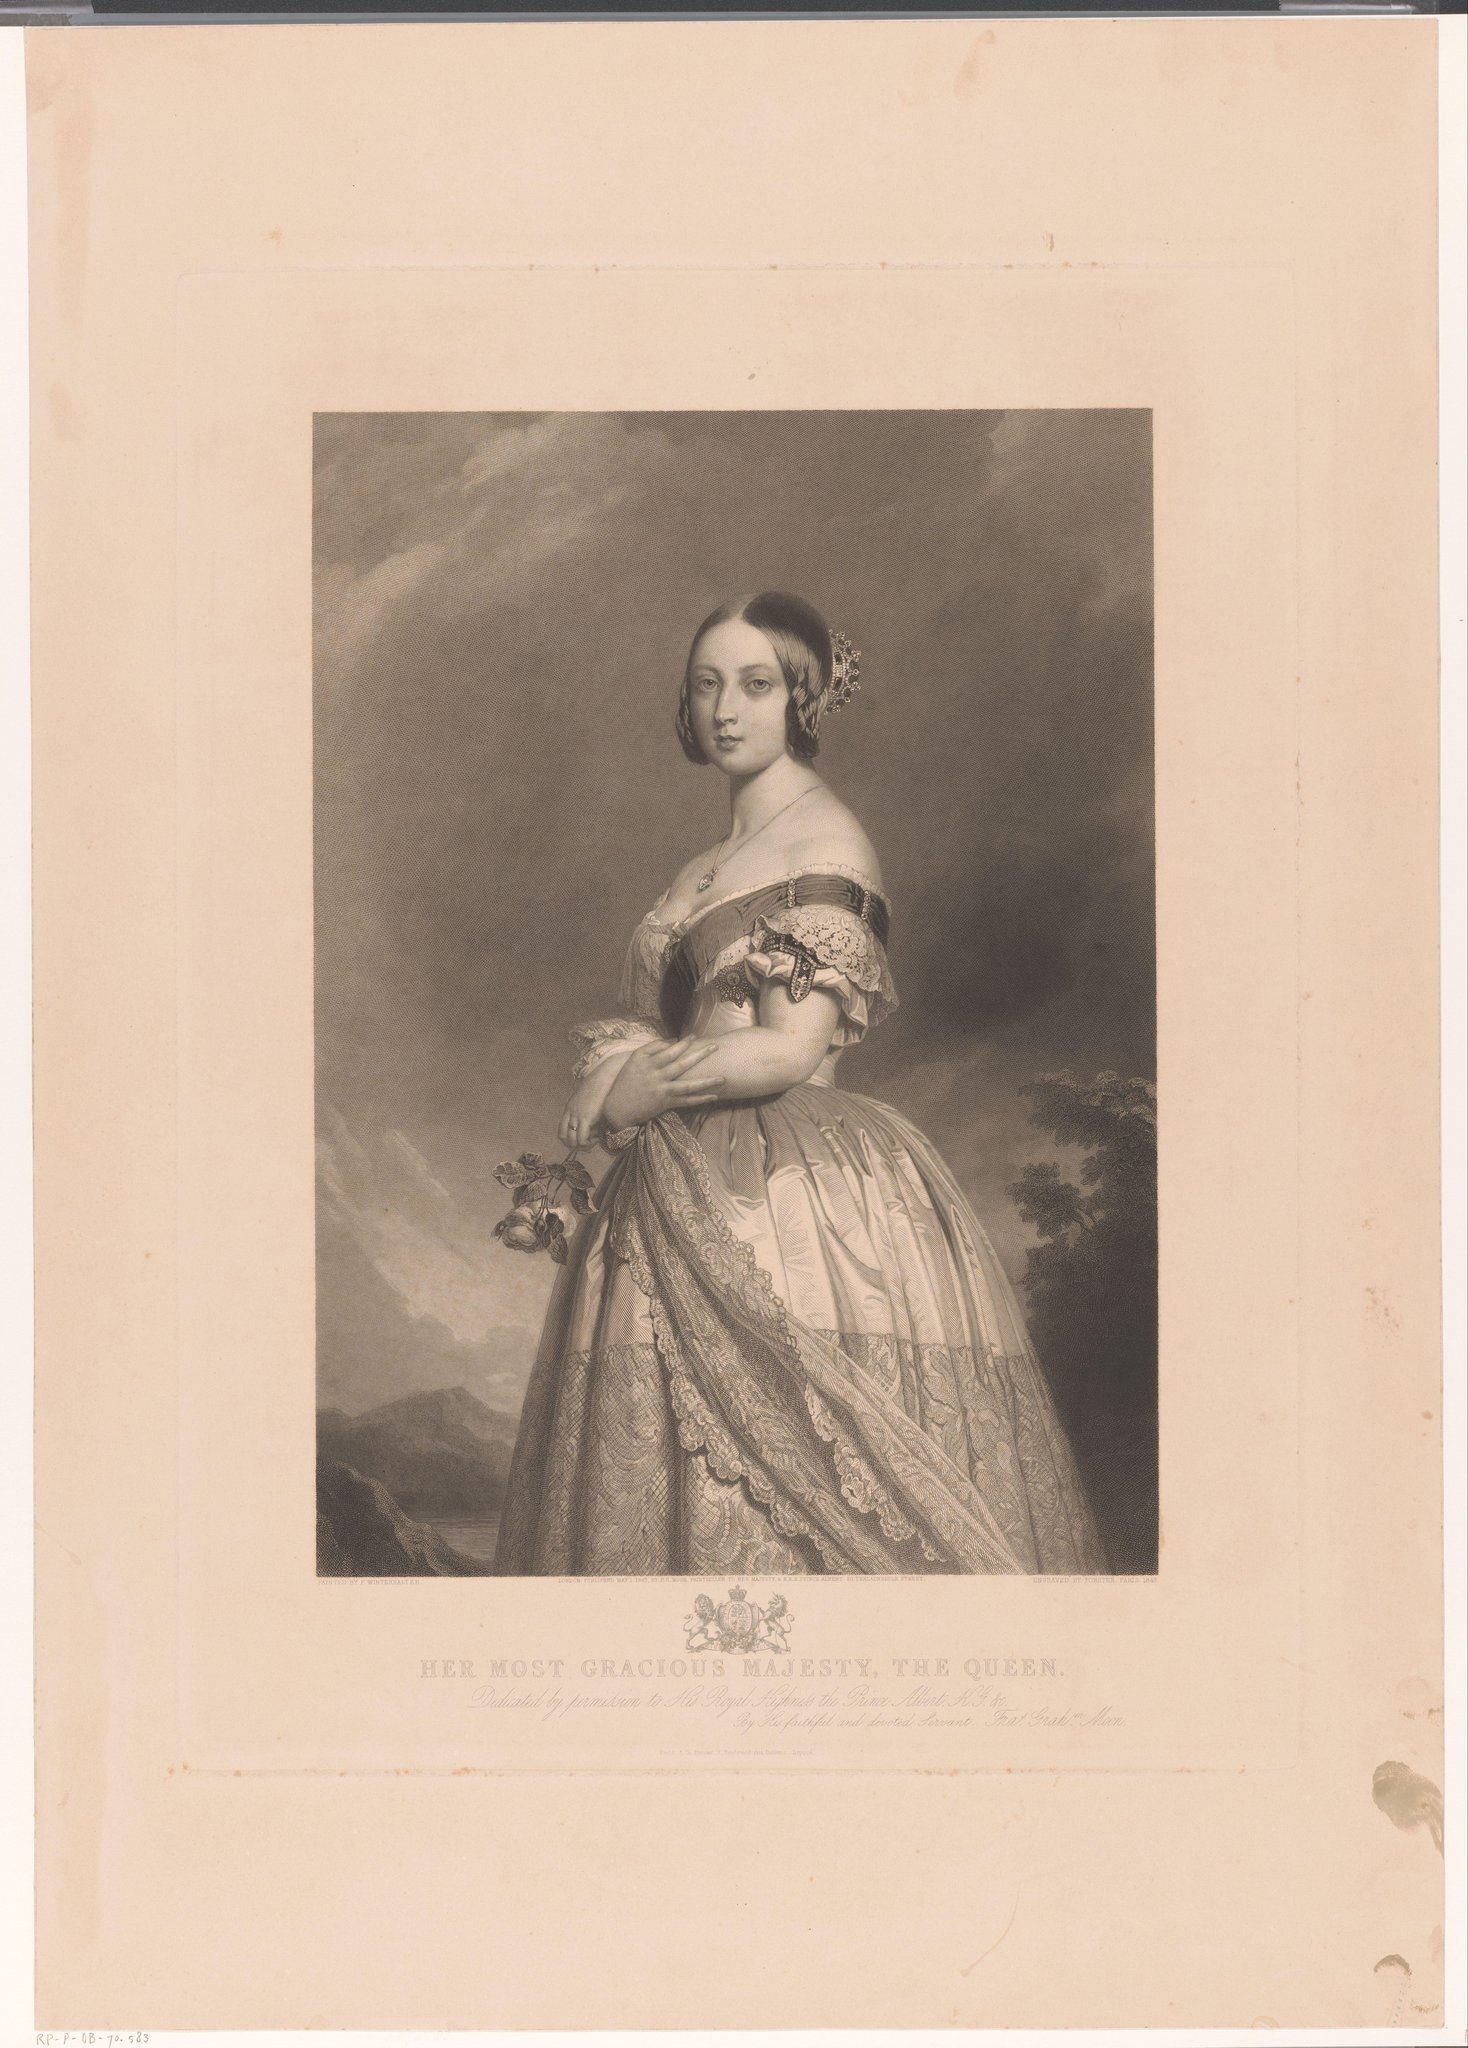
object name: print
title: Her most gracious majesty, the Queen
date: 1846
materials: paper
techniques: engraving, etching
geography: france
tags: victoria (koningin van het verenigd koninkrijk en keizerin van india), historical persons - bb - woman, queen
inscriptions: collector's mark: Lugt 12